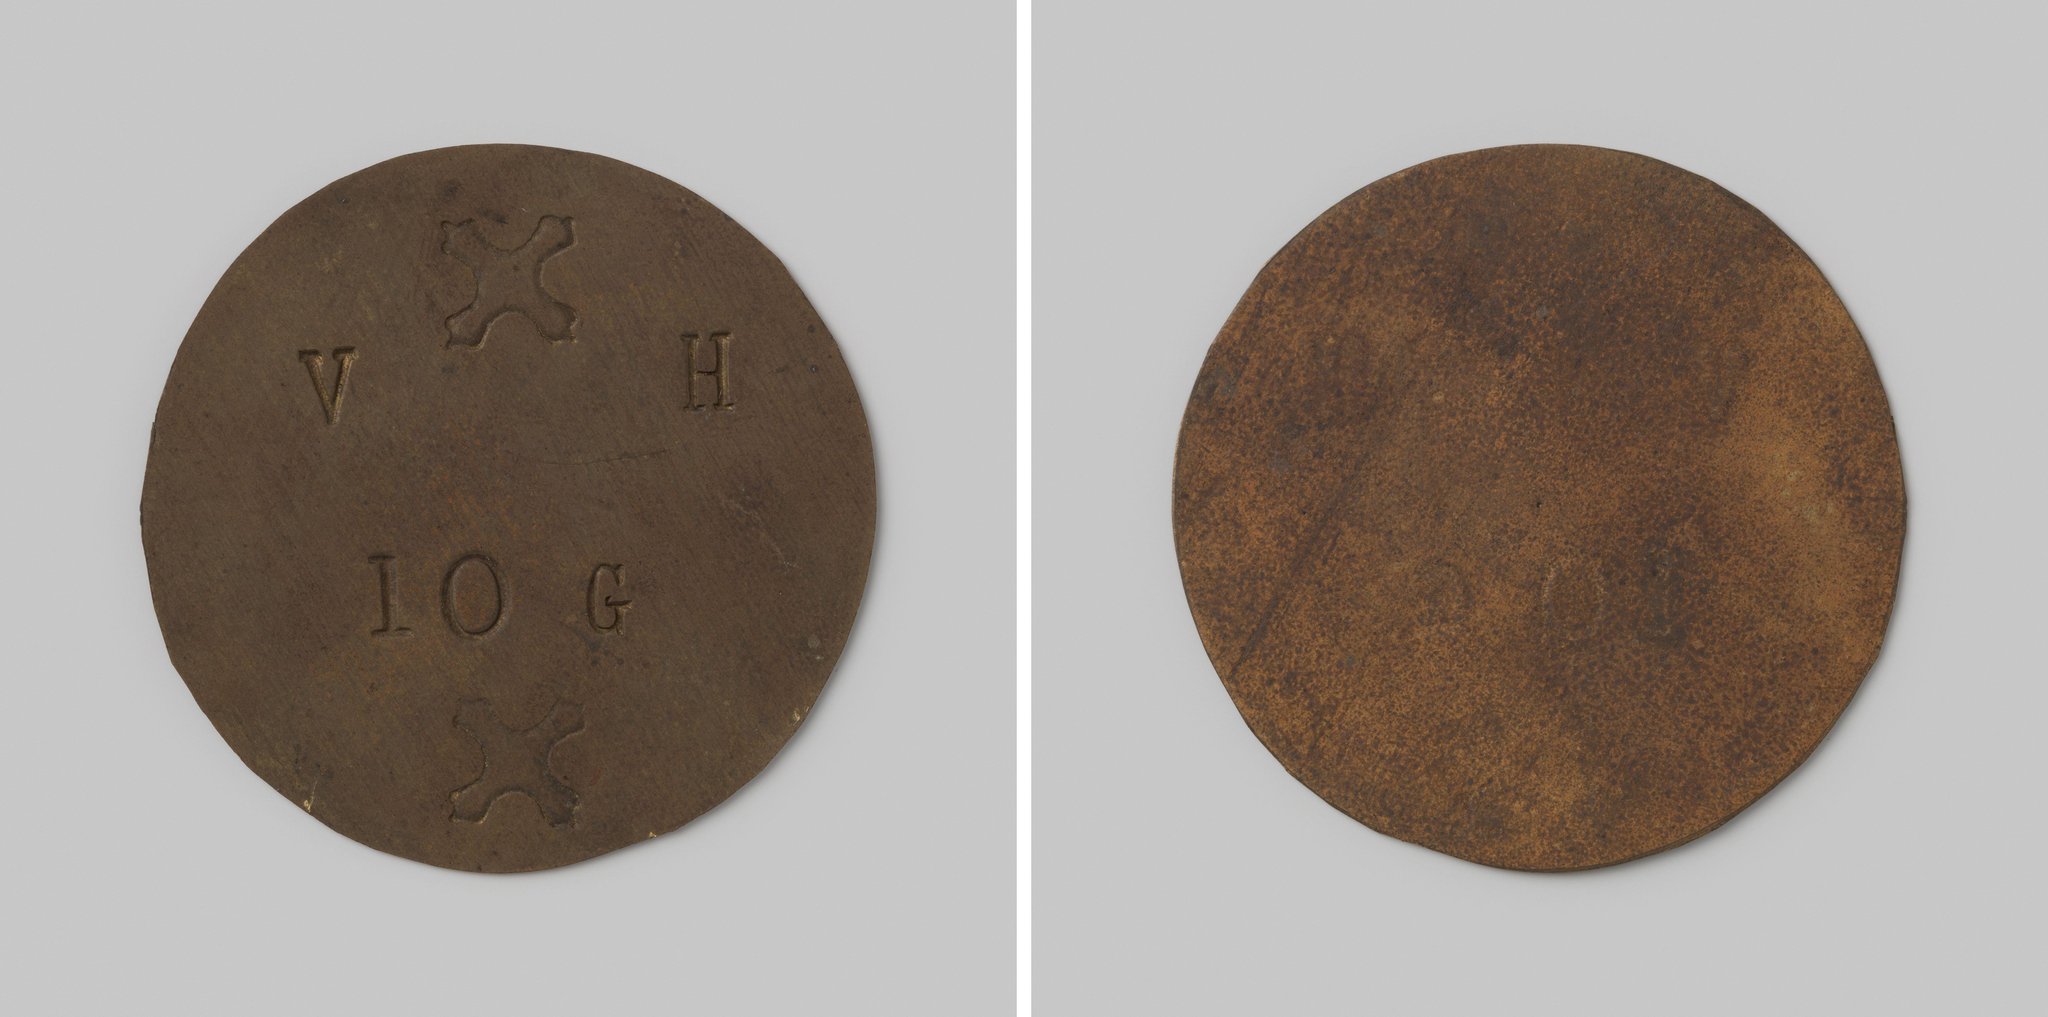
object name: monetary token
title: Betaalpenning van tien gulden van de Coöperatieve Winkelvereeniging De Volharding te Veenendaal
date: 1875-1900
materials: brass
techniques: printing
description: Rond messing plaatje met instempelingen (andreaskruis) / V H / 10 G / (andreaskruis)